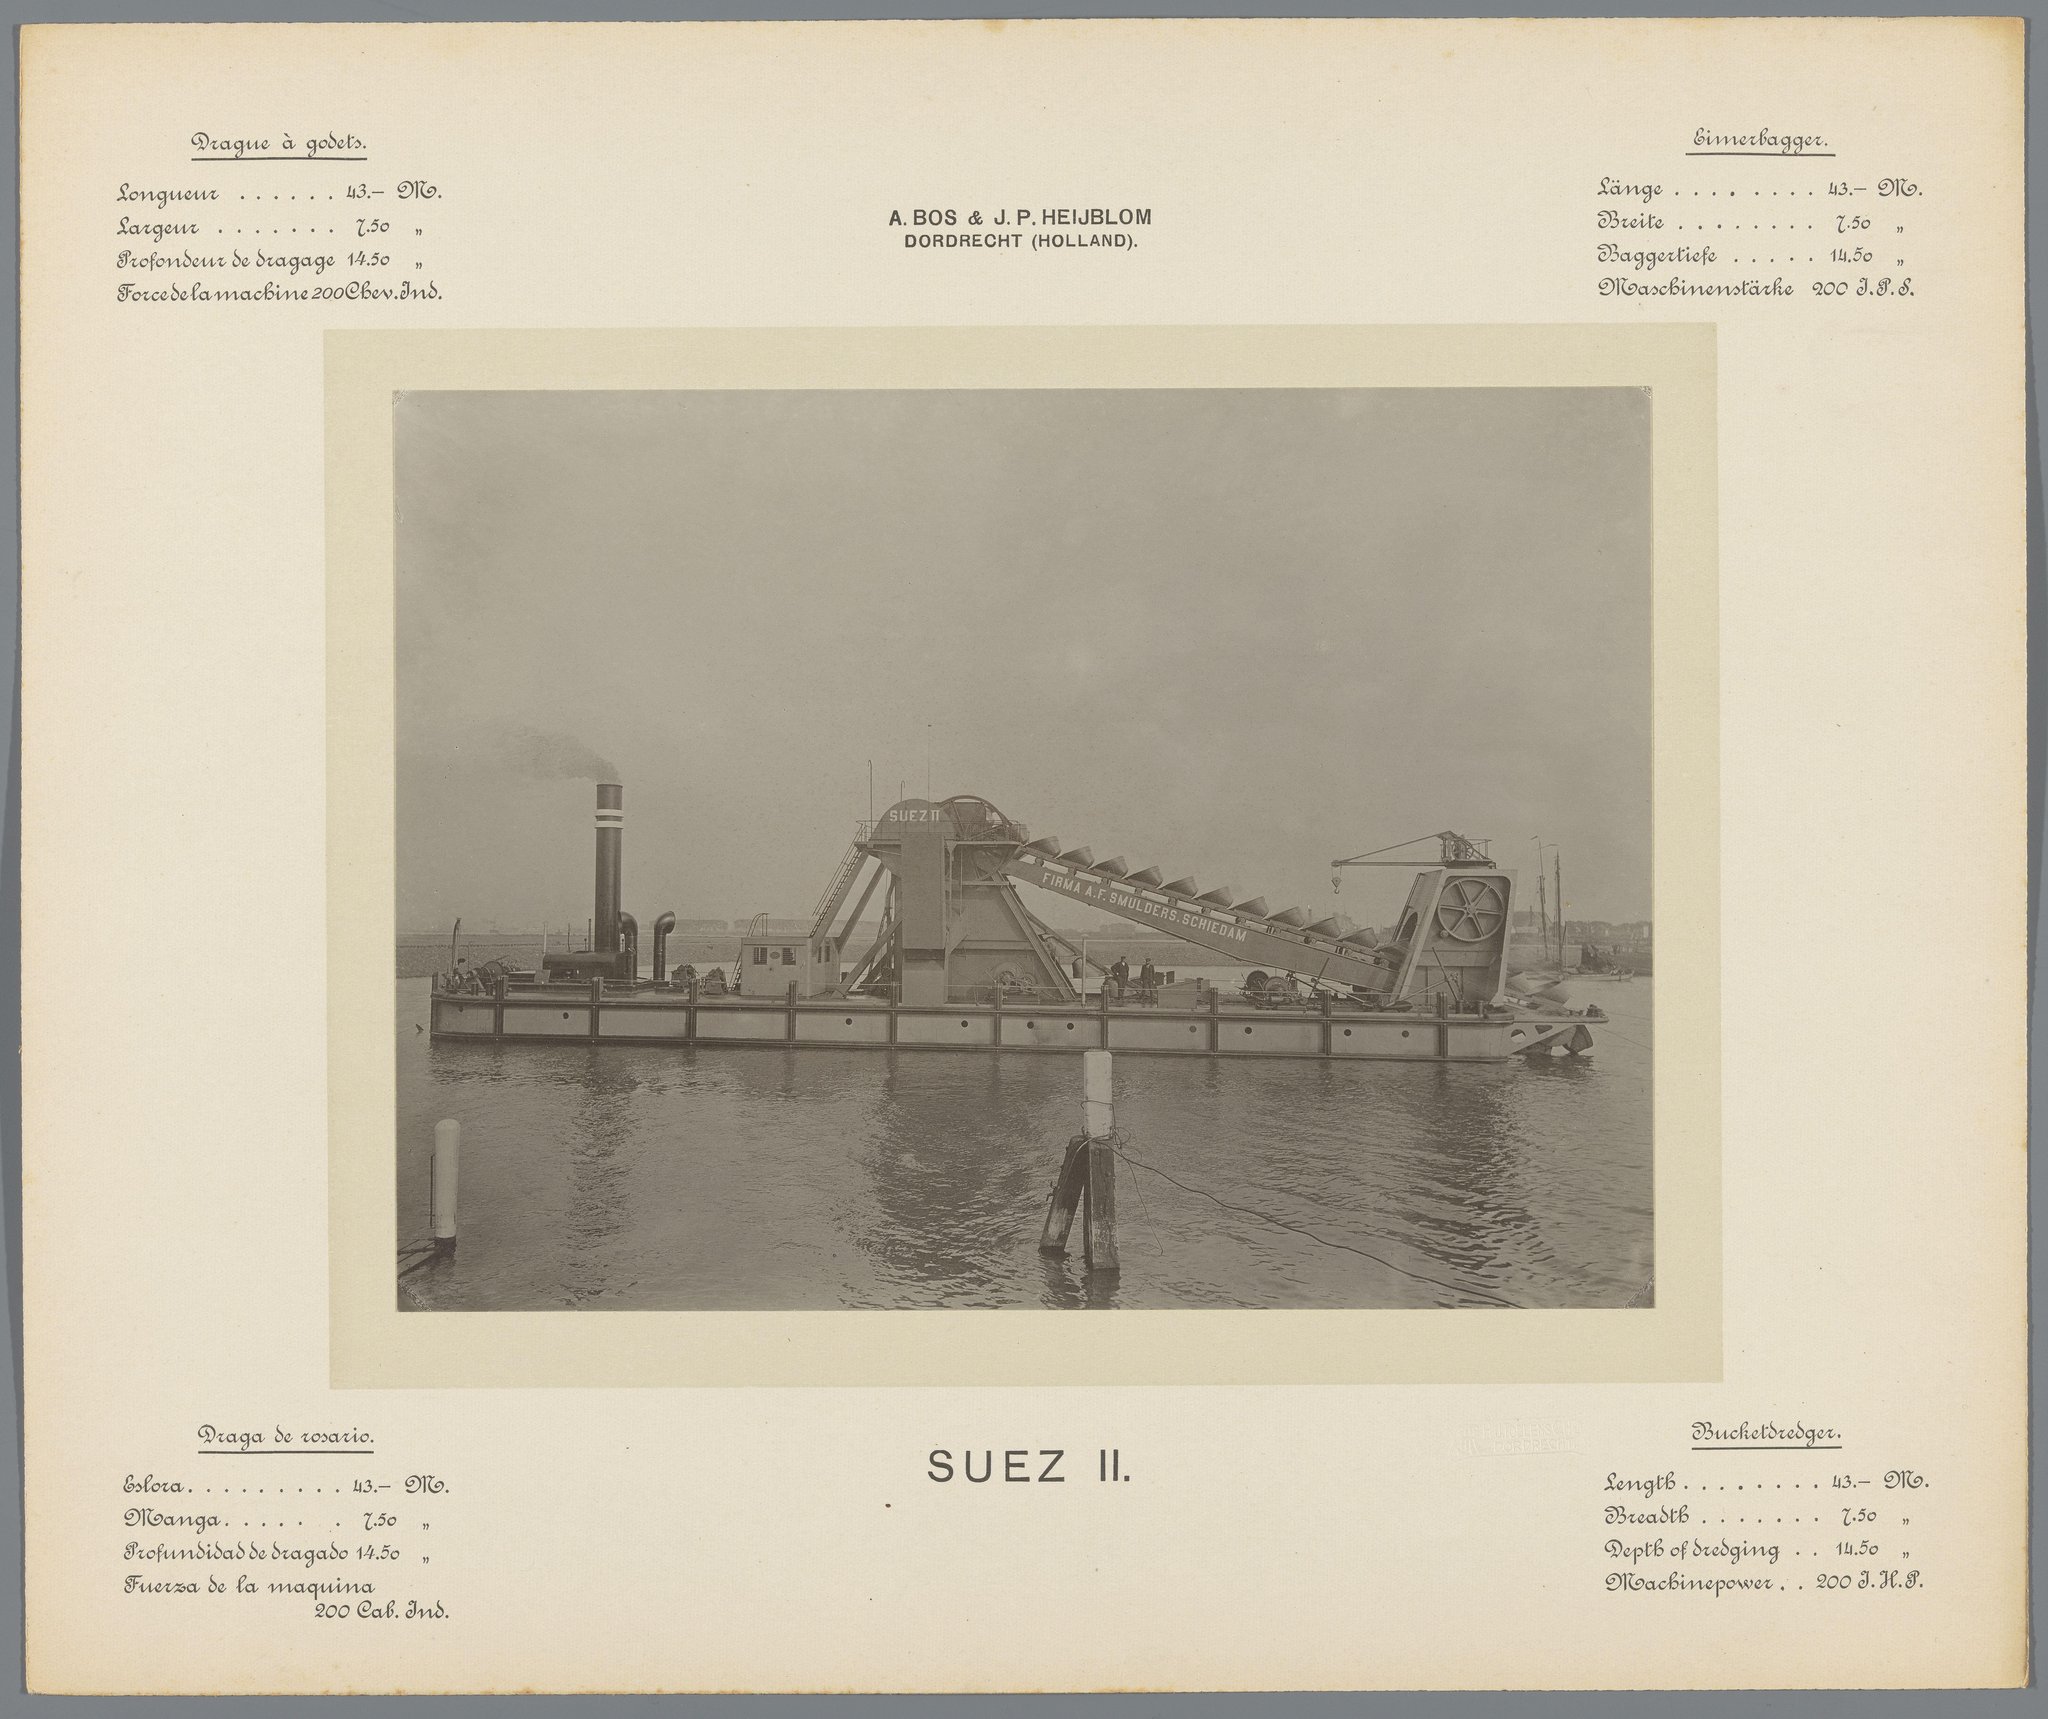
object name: photograph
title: Suez II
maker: henricus jacobus tollens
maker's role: painter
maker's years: 1864-1936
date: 1900-1910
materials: cardboard, photographic support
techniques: gelatin silver print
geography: dordrecht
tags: machine driven by steam, steamship, motorship (+ propulsion of vehicle, ship, etc. by steam), dredge, dredging machine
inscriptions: name: ‘H.J. Tollens C. Hzn. Dordrecht’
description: Emmerbaggermolen Suez II. Op het schip de bedrijfsnaam: Firma A.F. Smulders, Sliedrecht. Foto geplakt op karton met technische informatie over het schip in Duits, Frans, Spaans en Engels. Onderdeel van de map met 44 foto's van baggerschepen van de firma A. Bos & J.P. Heijblom te Dordrecht.